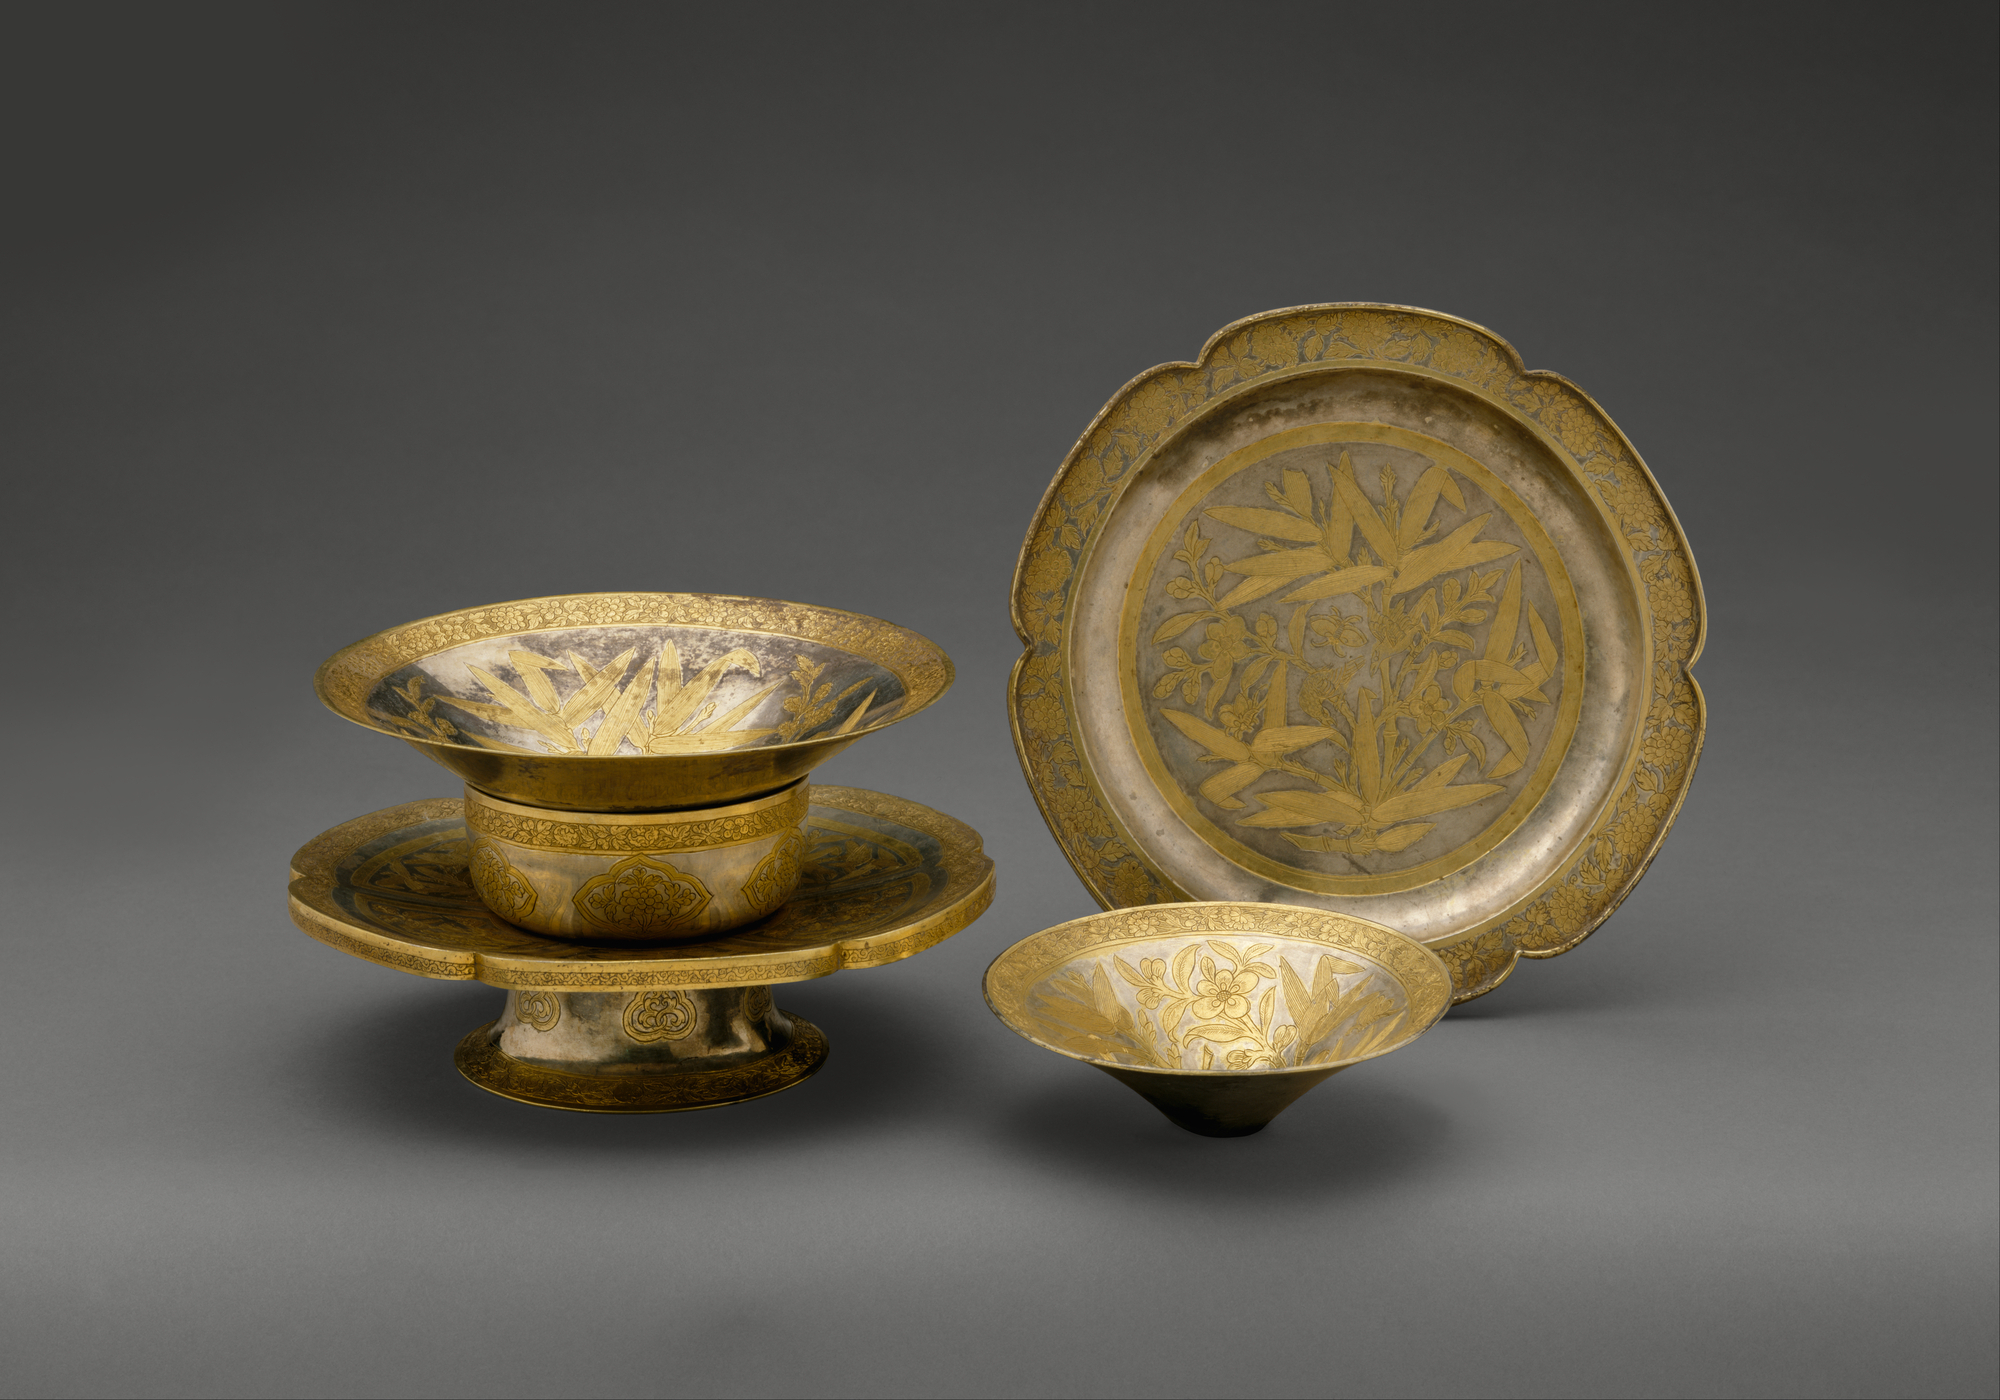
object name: service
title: Service with Decoration of Flowers and Birds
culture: chinese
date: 1267-1333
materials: silver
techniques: gilding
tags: flowers